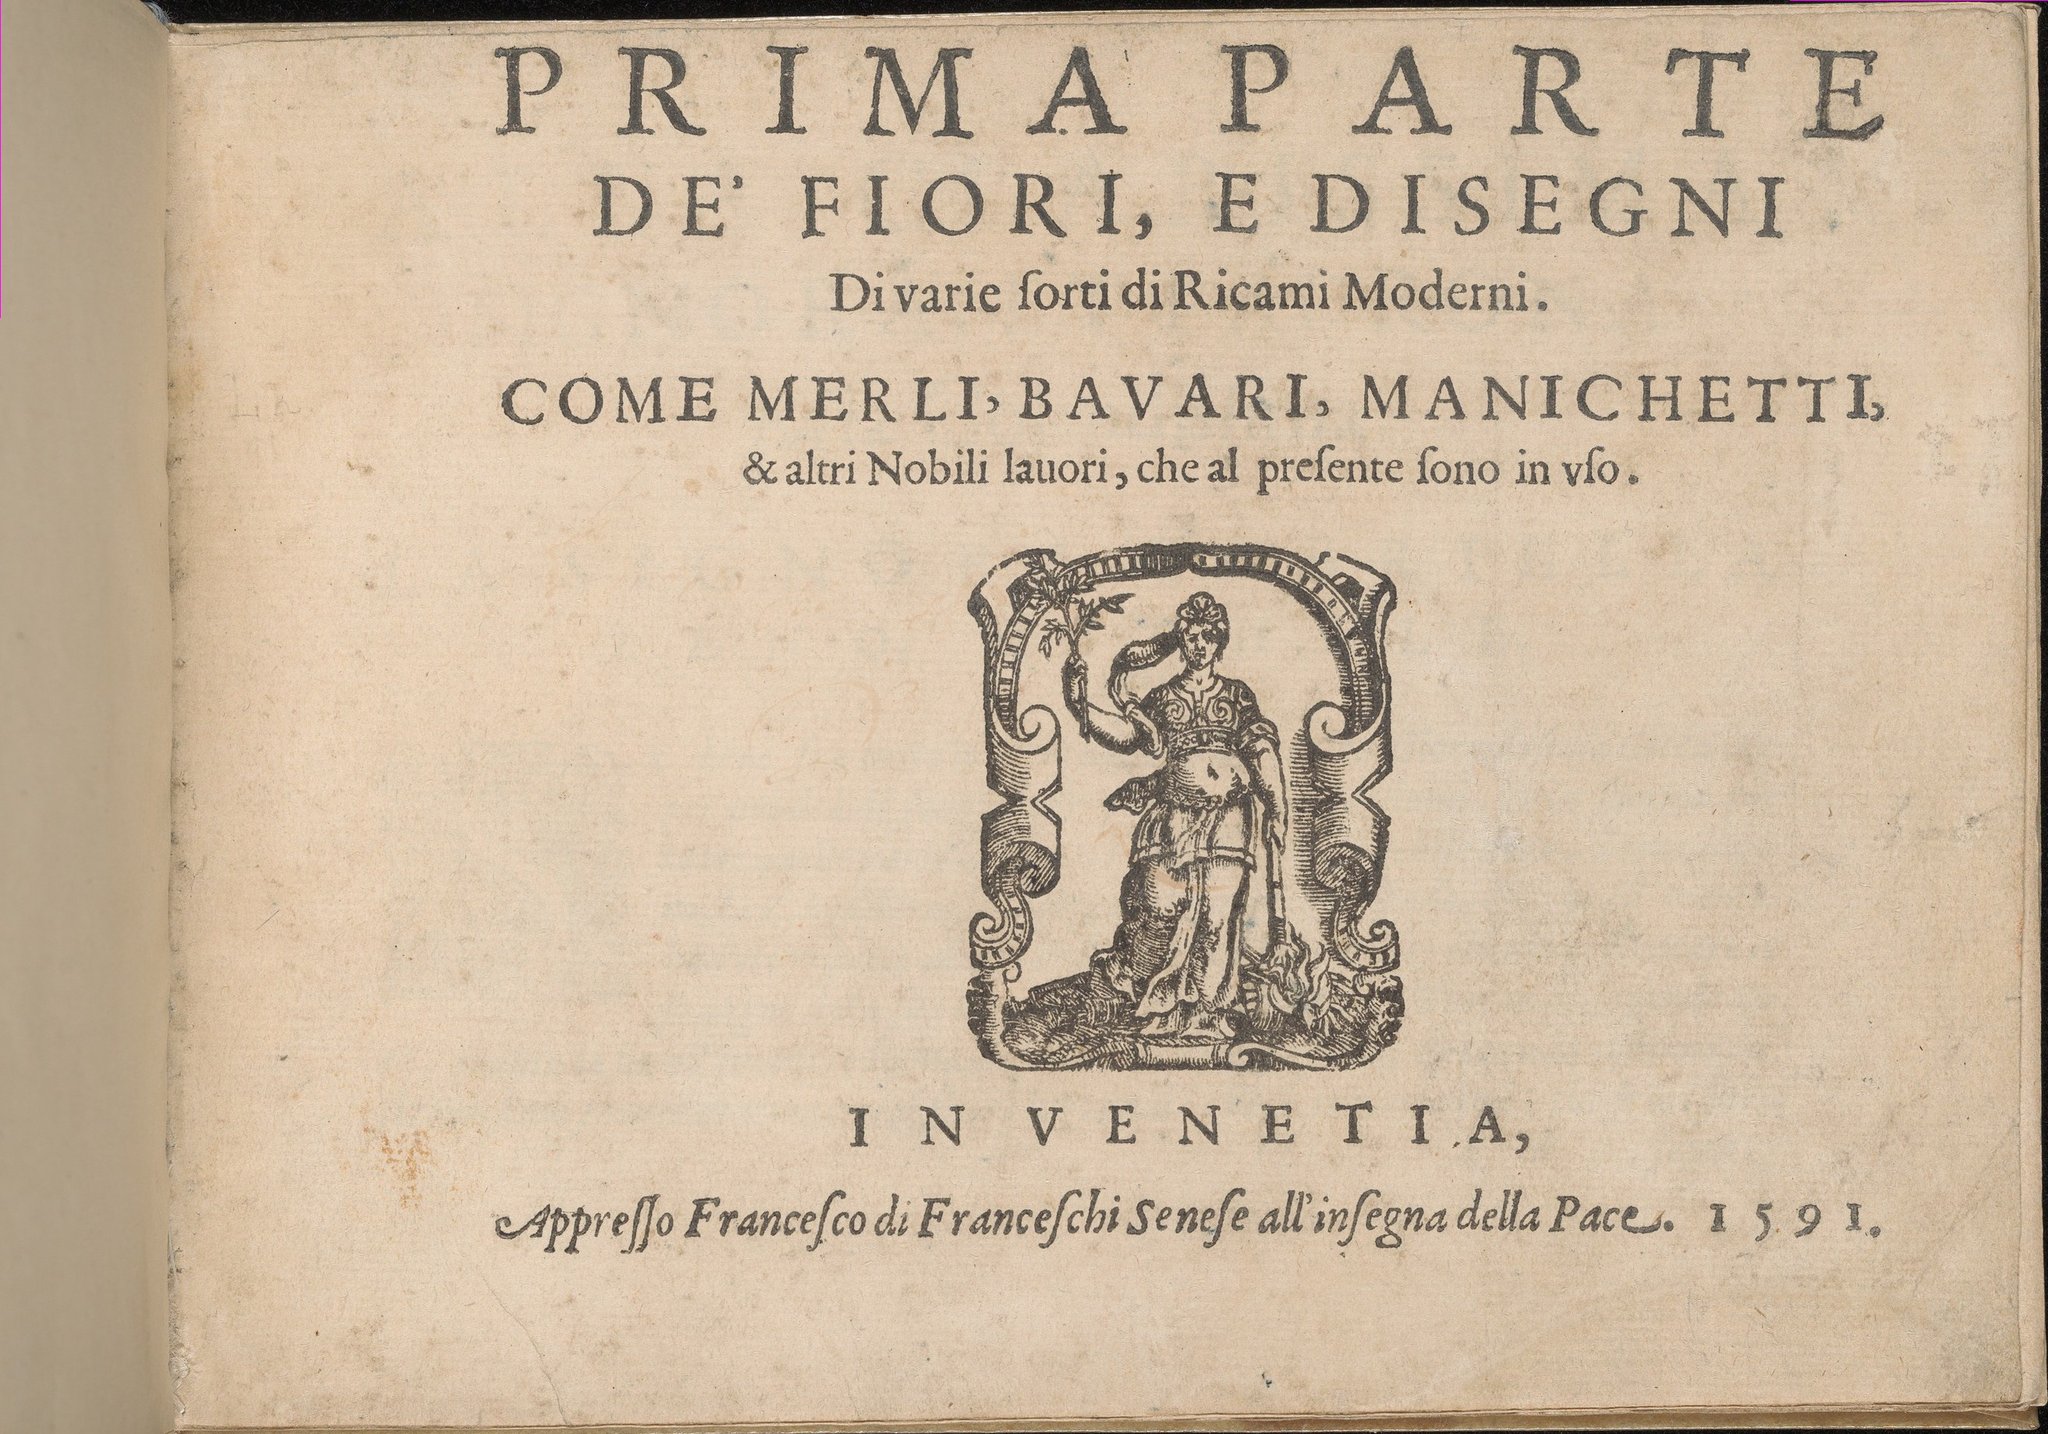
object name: book print ornament architecture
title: Prima Parte de' Fiori, e Disegni di varie sorti di Ricami Moderni, title page (recto)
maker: giovanni battista ciotti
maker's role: author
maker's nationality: italian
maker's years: 1555-1659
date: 1591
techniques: woodcut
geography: italy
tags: women